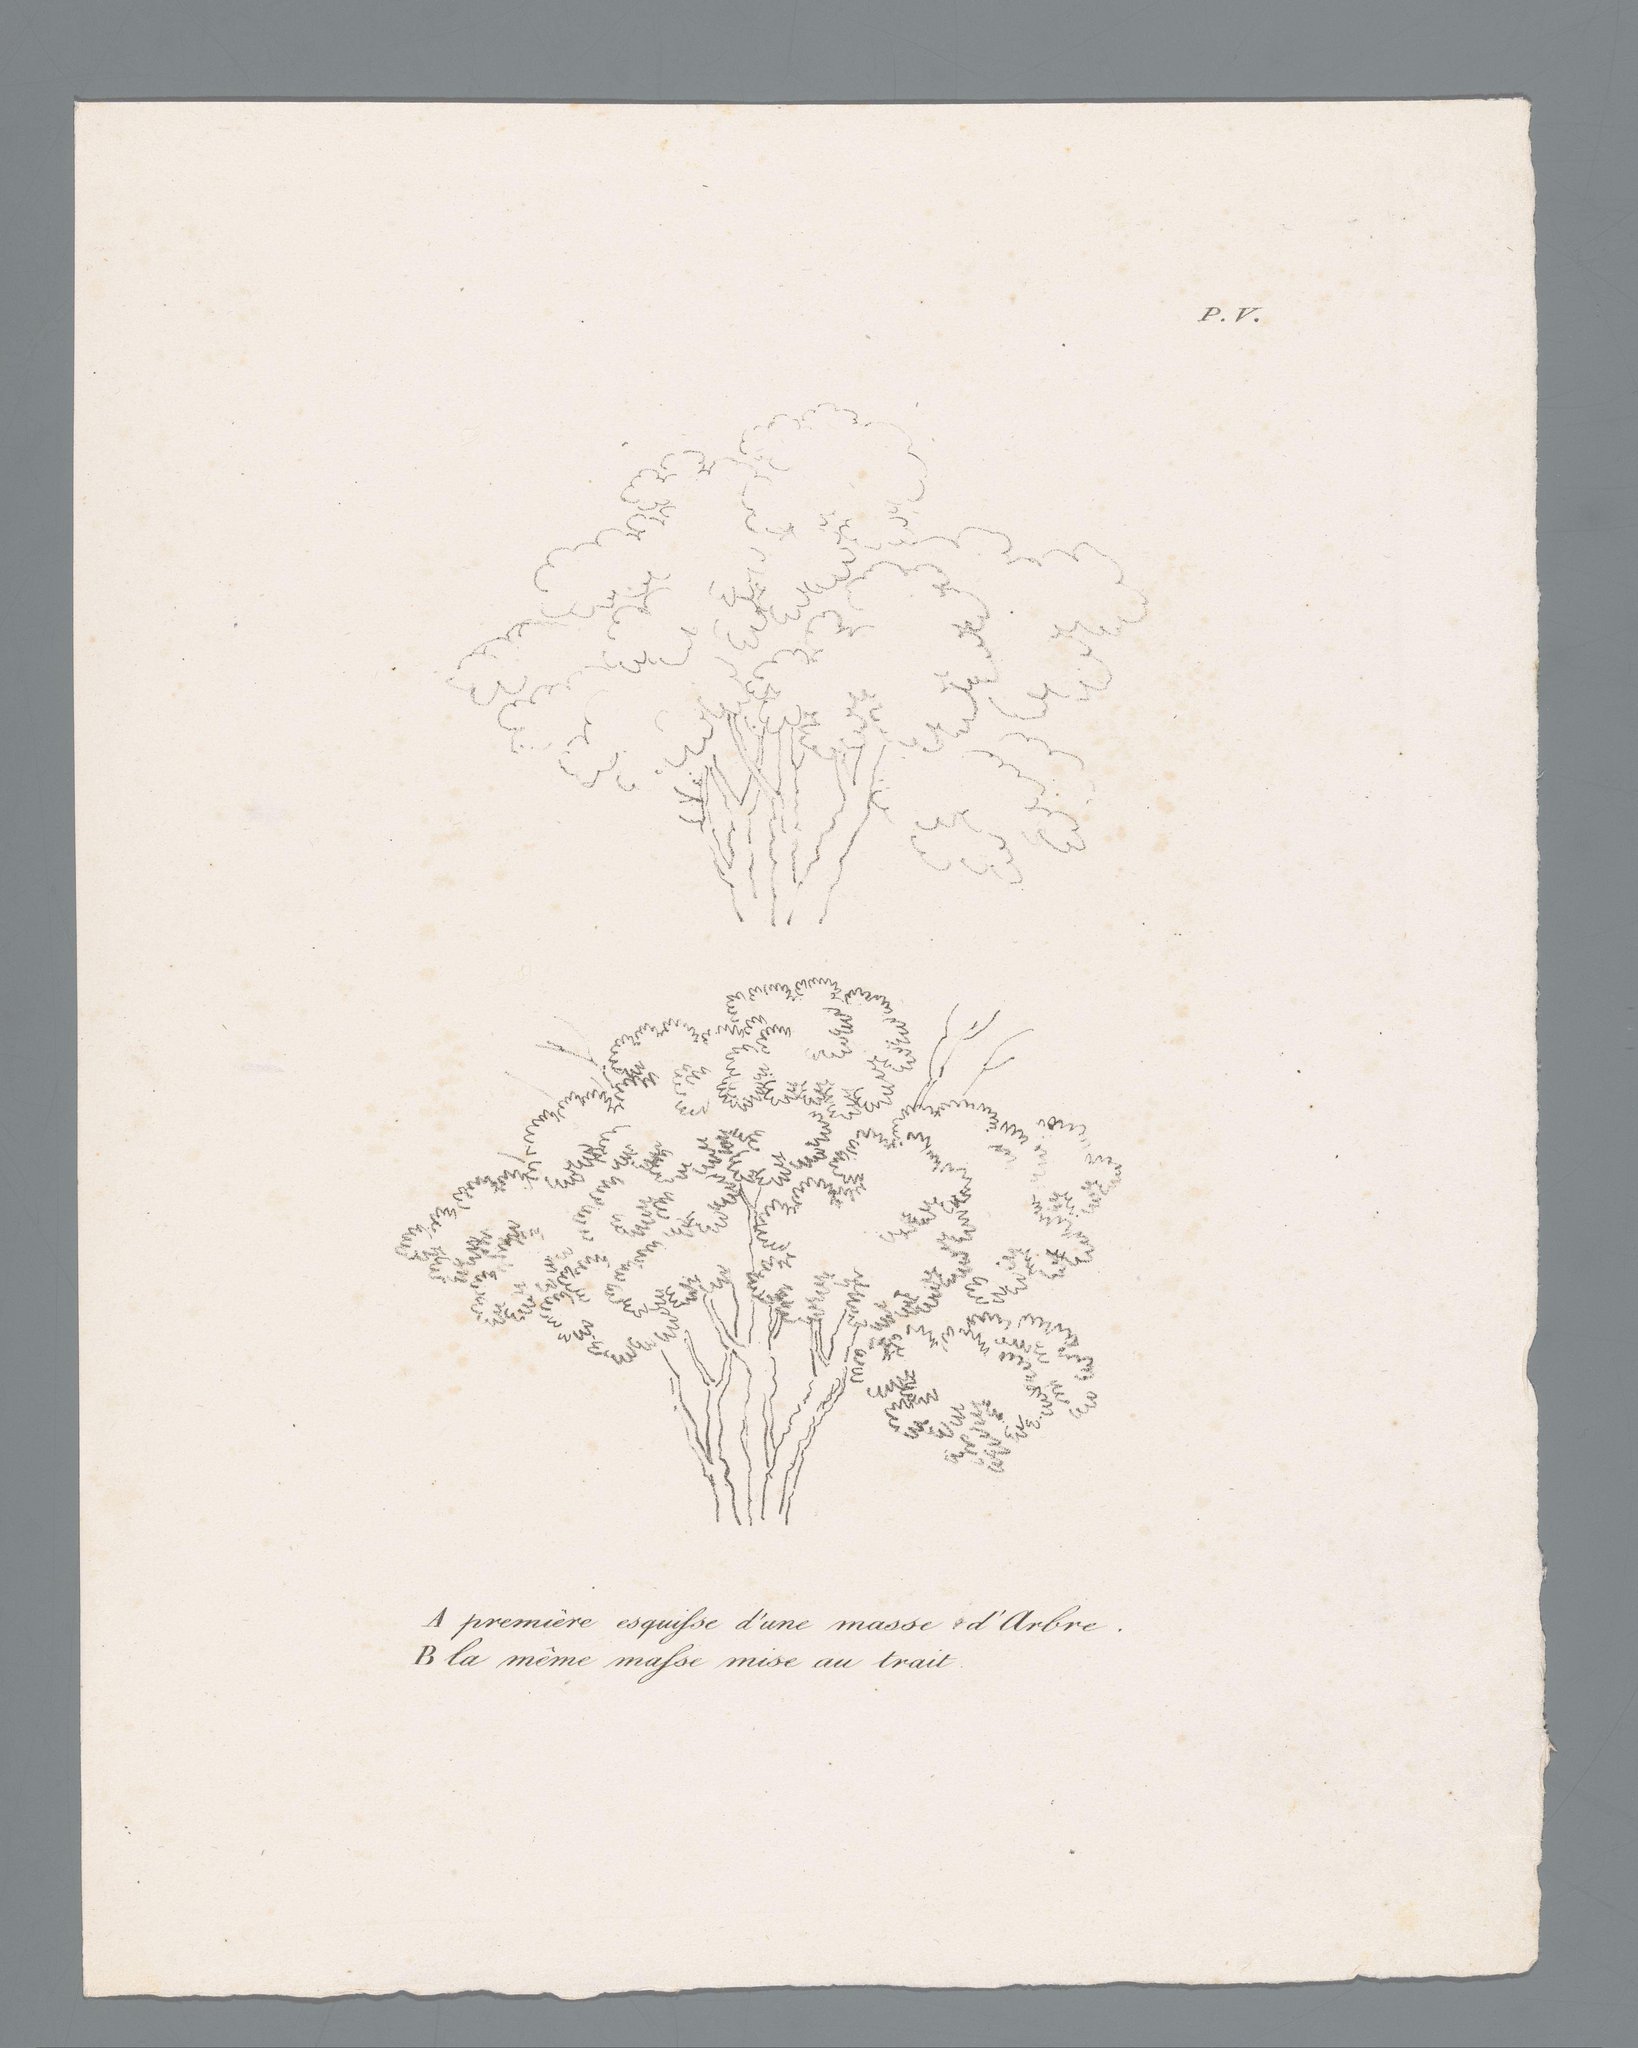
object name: print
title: Studie van twee boomtoppen in diverse tekenfasen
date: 1820-1833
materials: paper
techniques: lithograph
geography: paris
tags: trees (+ top of plant)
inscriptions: collector's mark: Lugt 2228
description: De eerste en tweede tekenfase: schets en lijntekening.